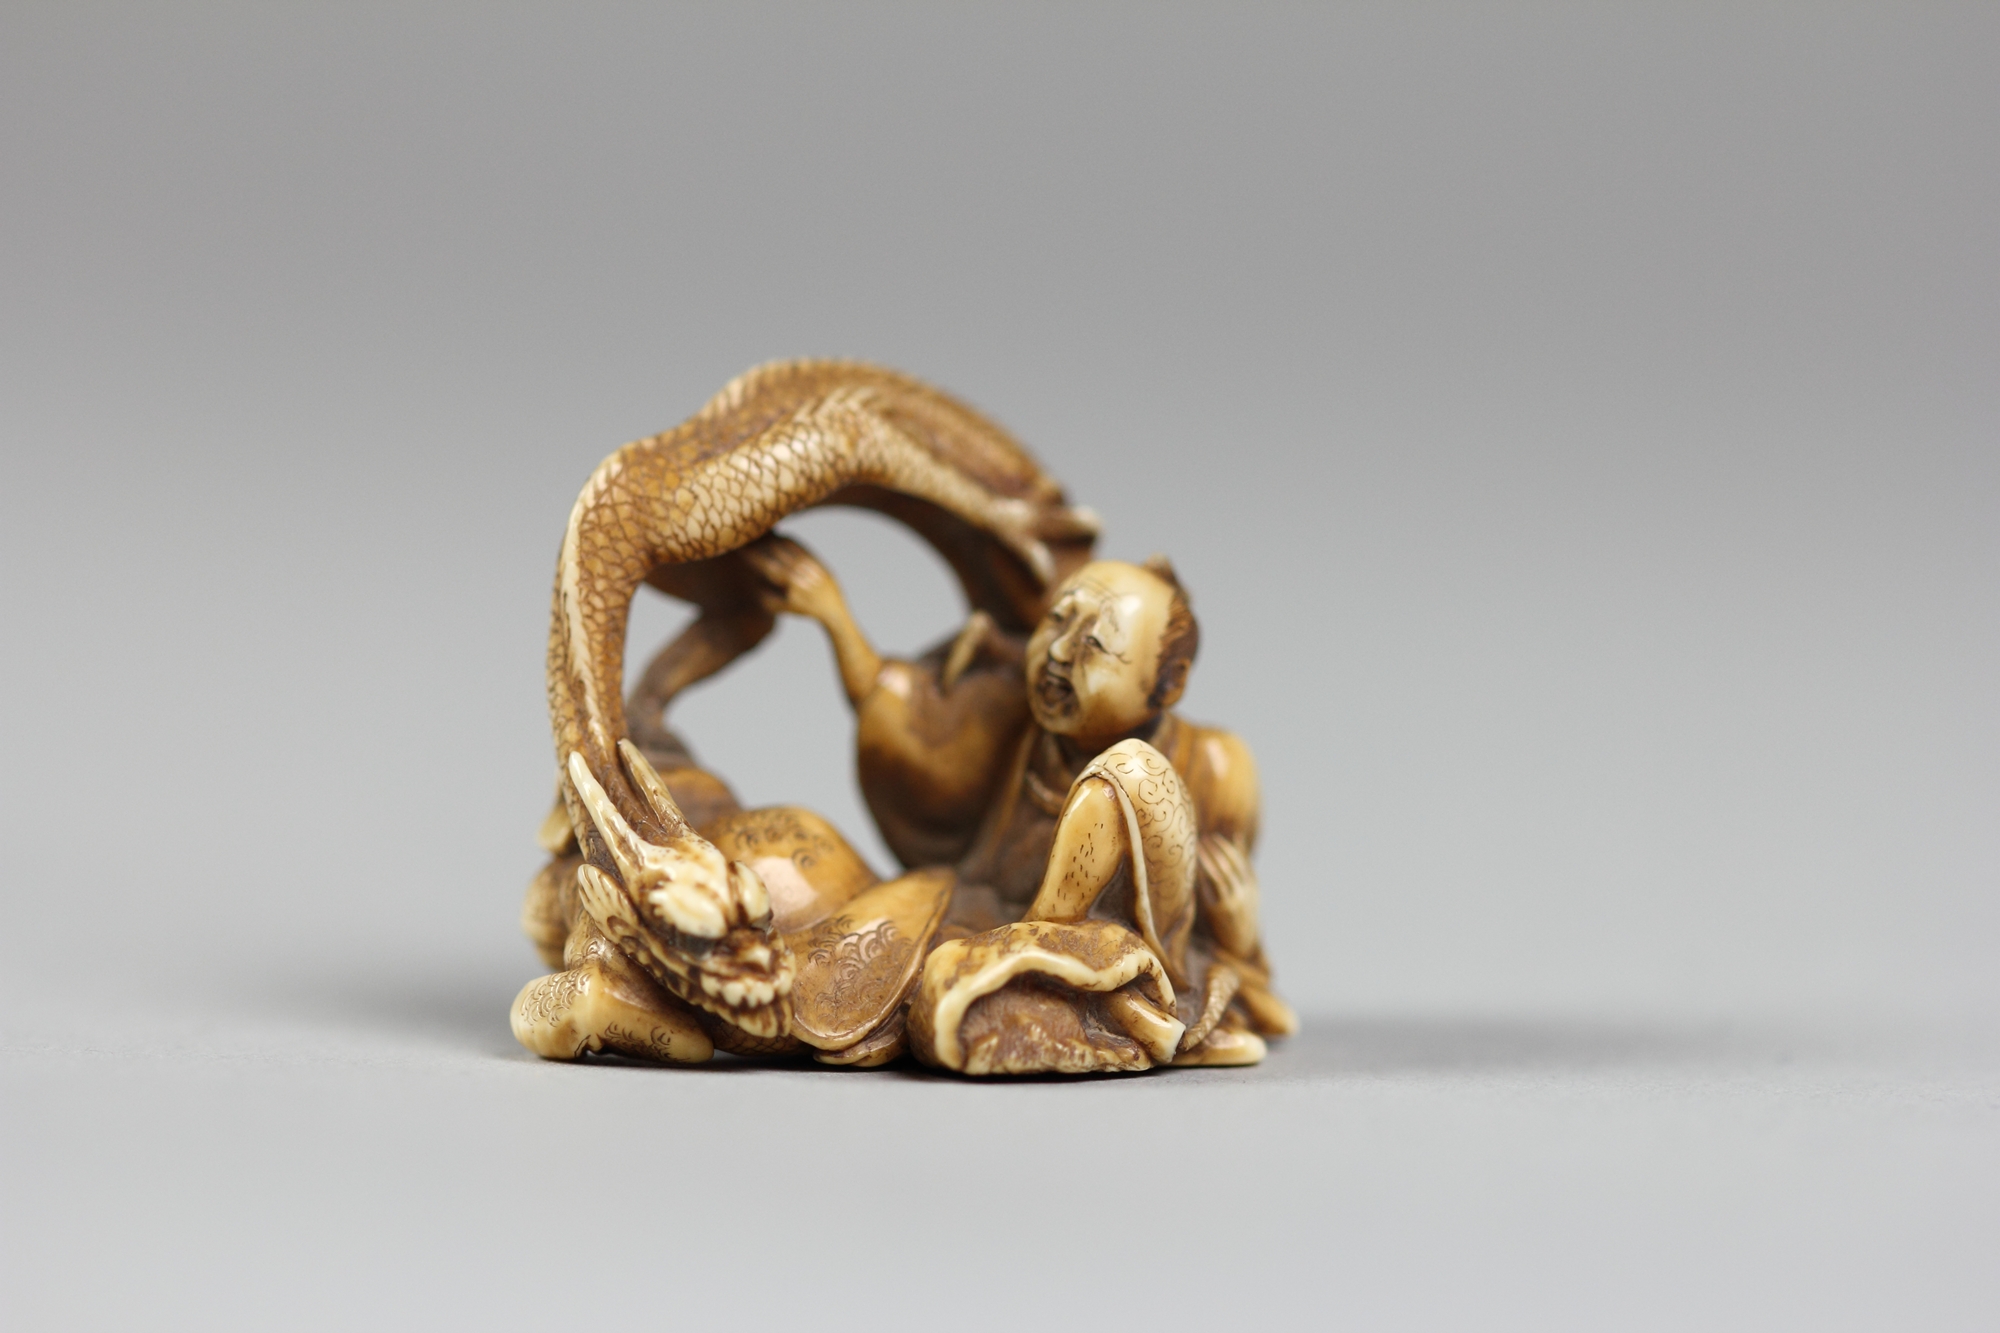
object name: netsuke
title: Netsuke of Two Figures and a Dragon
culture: japanese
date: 1801-1900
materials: ivory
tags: men